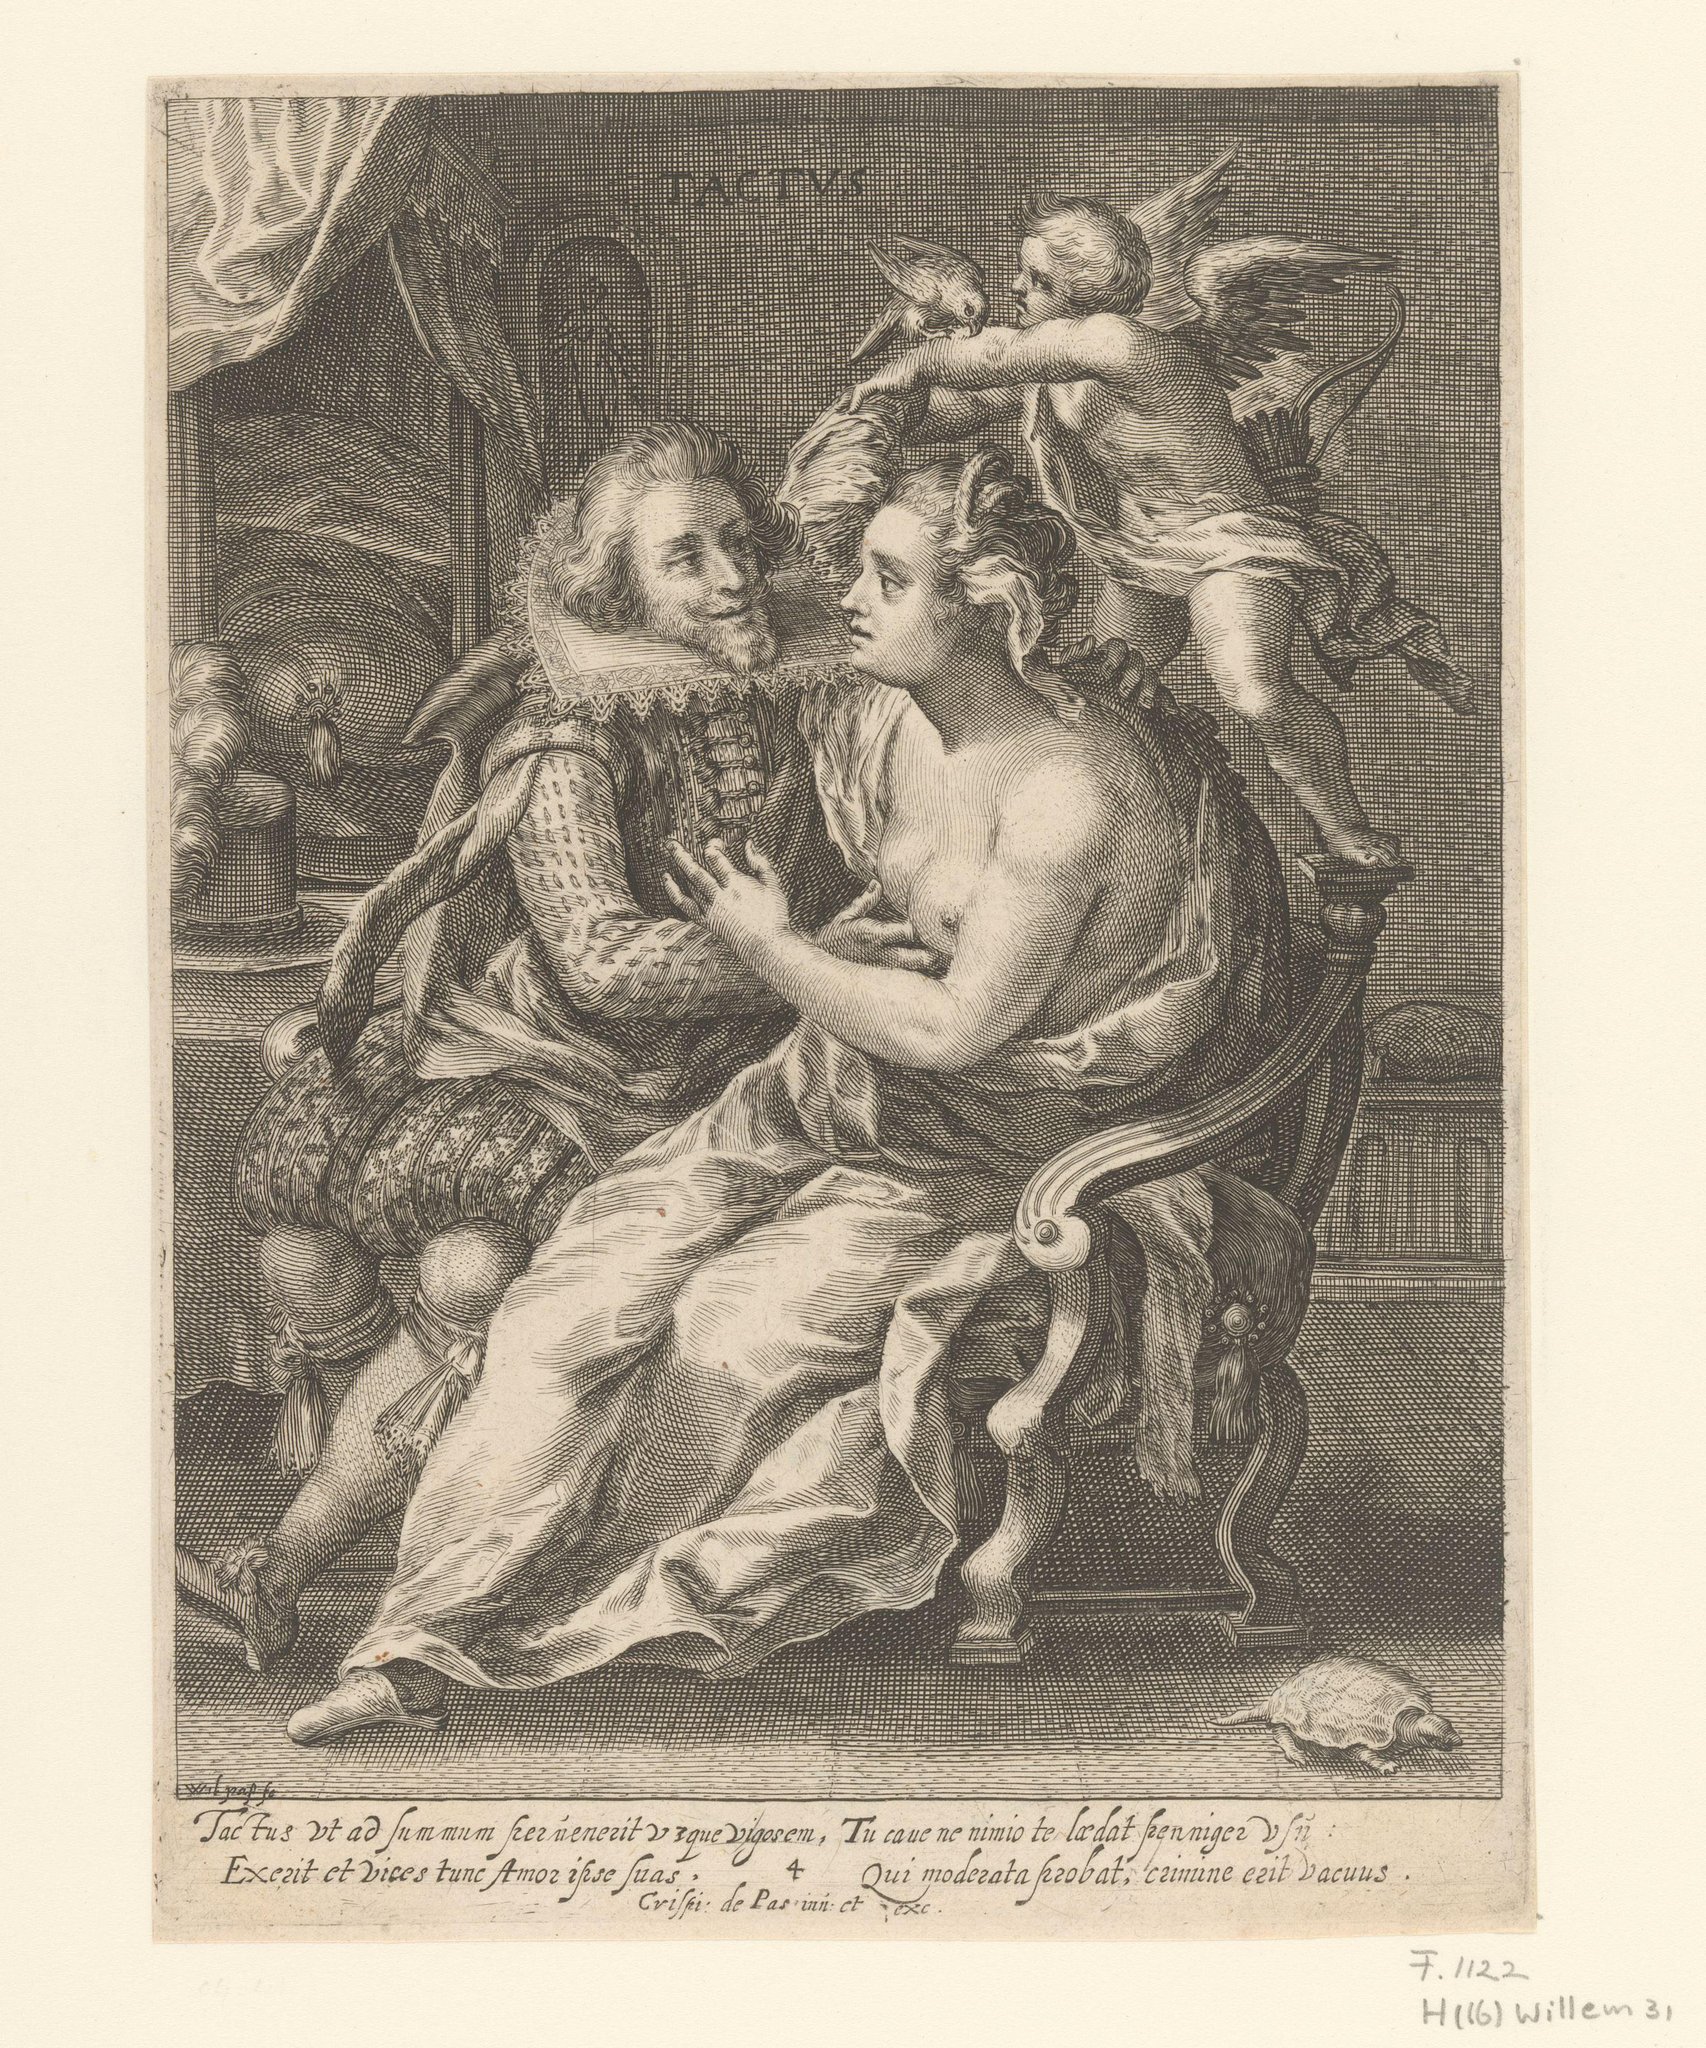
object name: print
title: Tactvs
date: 1607-1637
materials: paper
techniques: engraving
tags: taste, tasting (one of the five senses), fettered cupid, 'amor cruciatus'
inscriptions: collector's mark: Lugt 2228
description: Vertrek met de personificatie van de tastzin die een man omhelst. Op haar stoel staat Amor die door een papegaai gebeten wordt. Op de voorgrond een schildpad. In de marge een vierregelig onderschrift, in twee kolommen, in het Latijn.